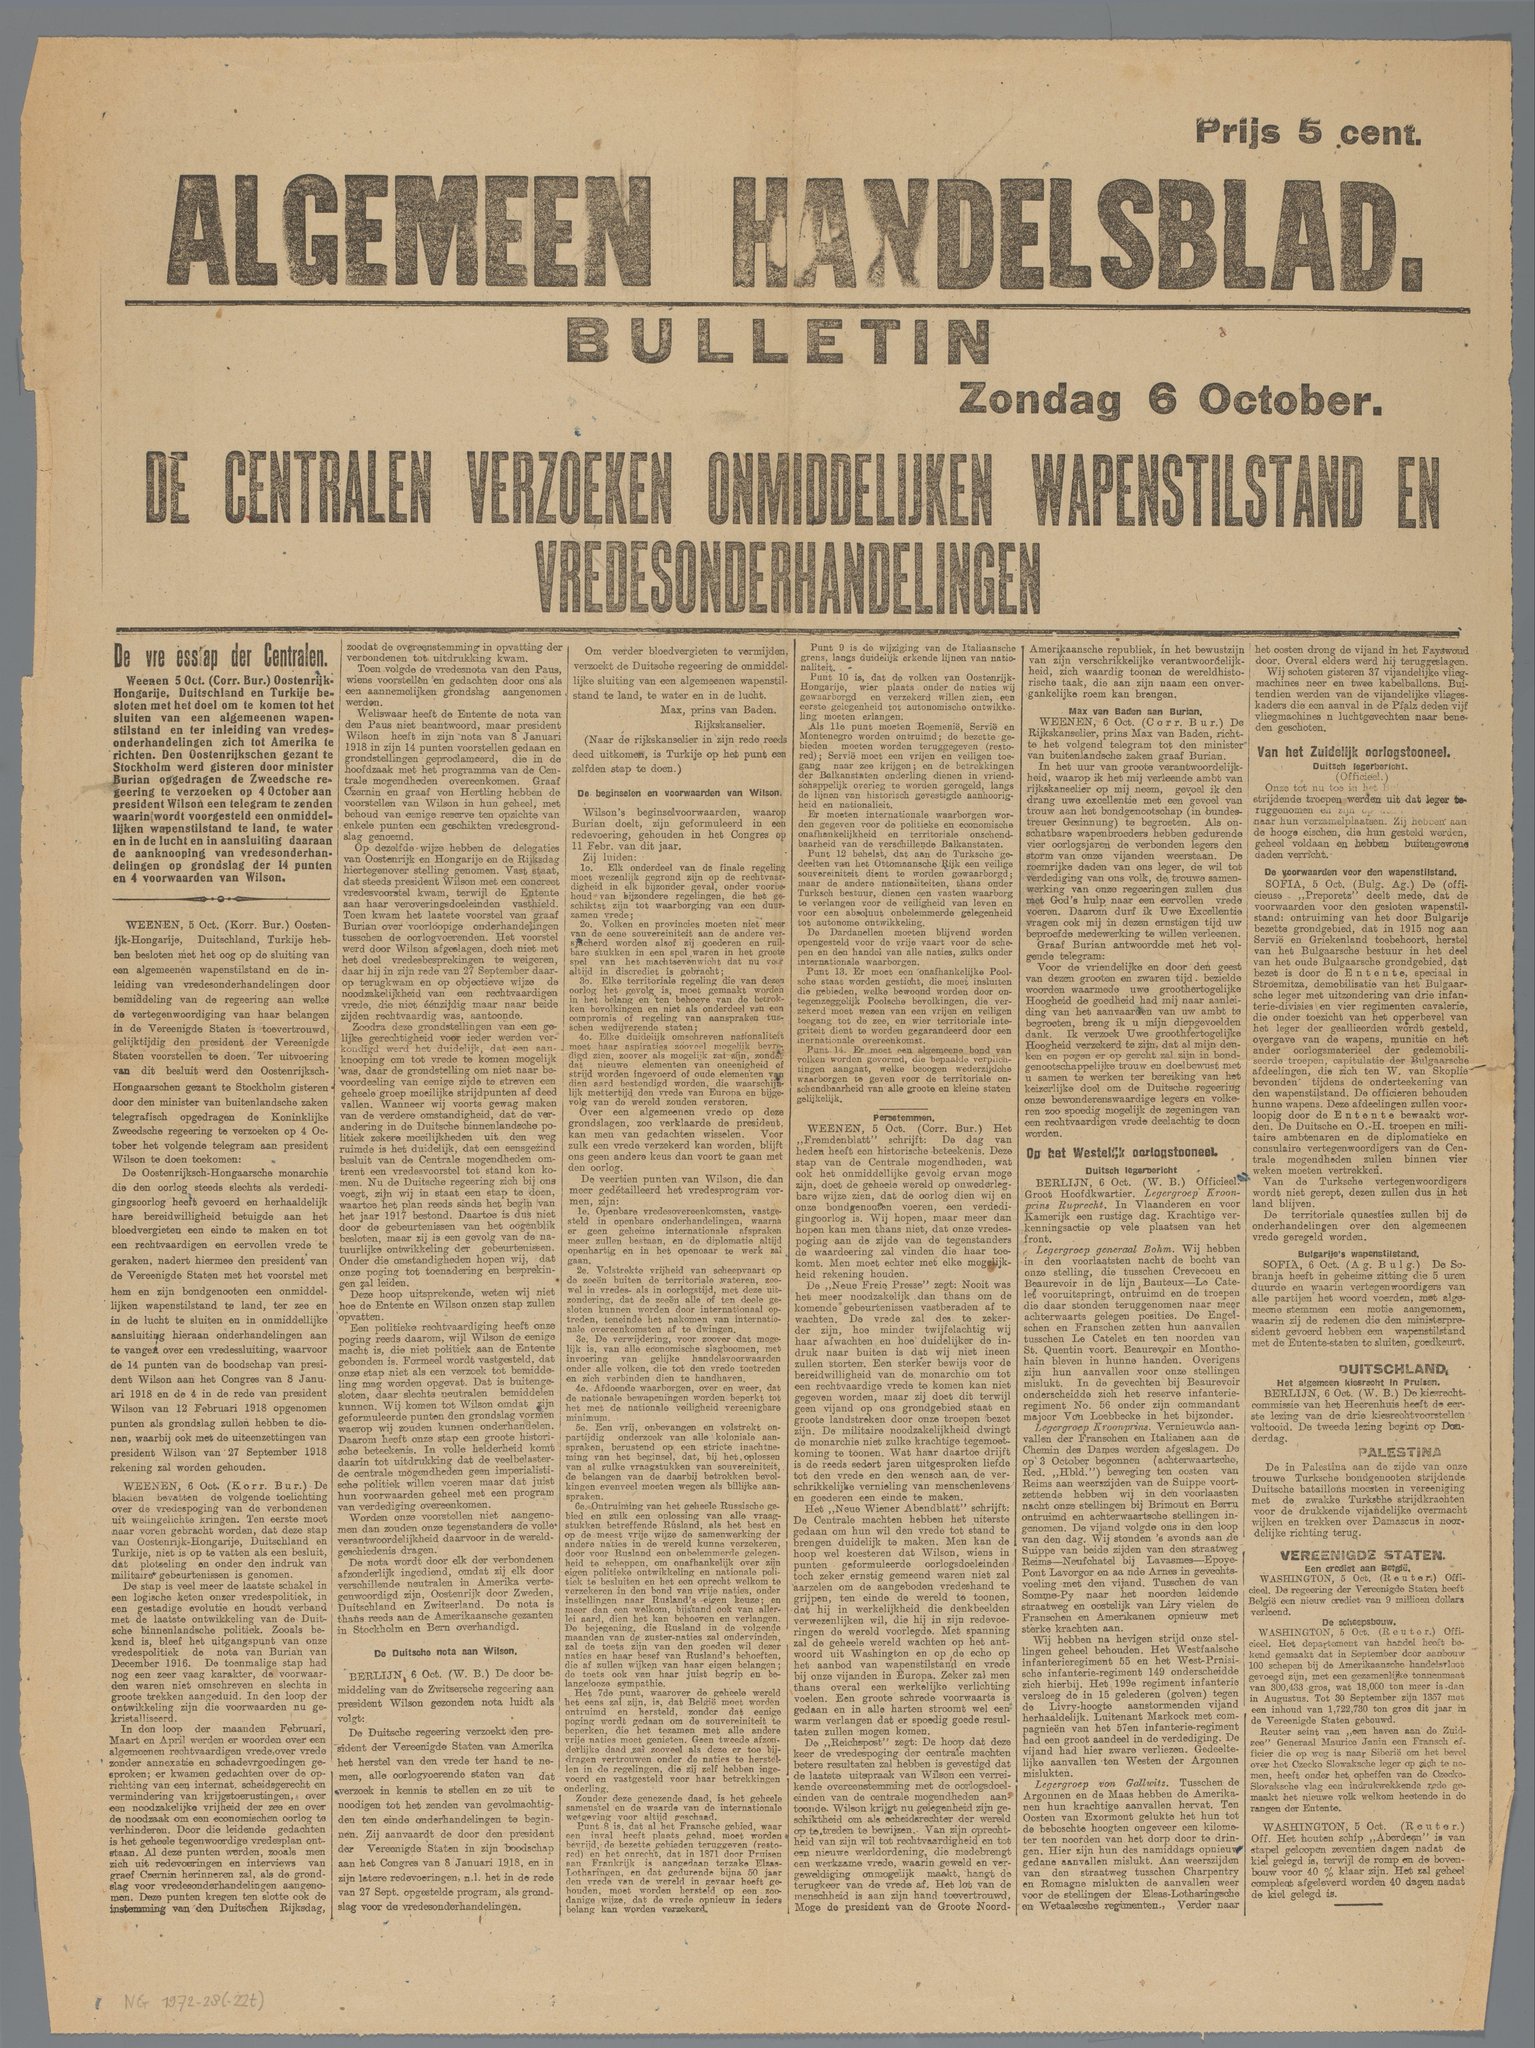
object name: newspaper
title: Algemeen Handelsblad Bulletin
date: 1918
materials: paper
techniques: printing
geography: amsterdam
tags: newspaper, netherlands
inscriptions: date